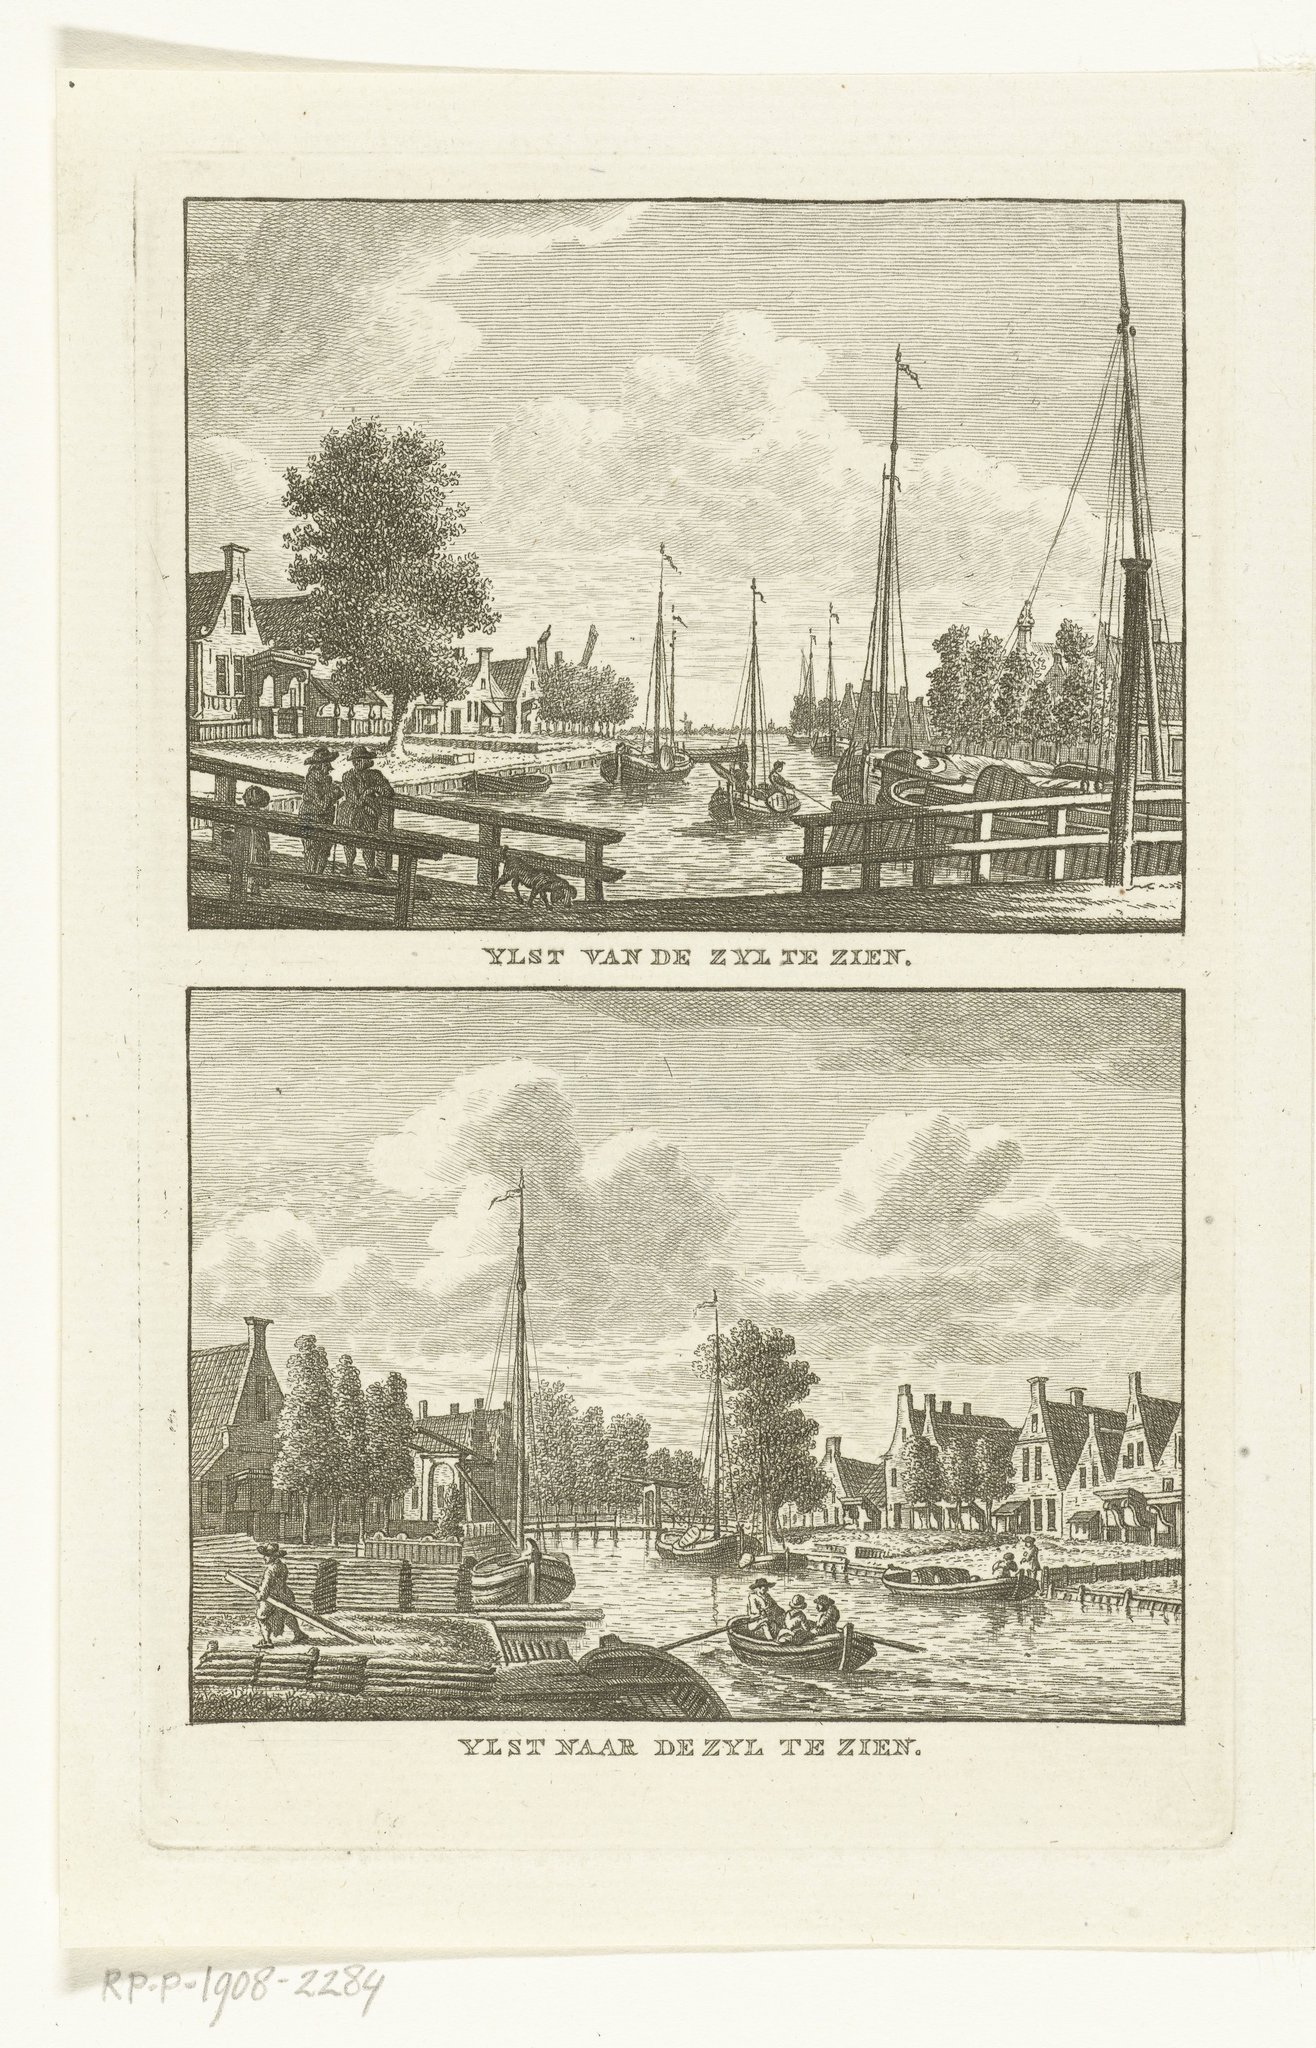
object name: print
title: Ylst naar de zijl gezien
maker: carel frederik bendorp (i)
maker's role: print maker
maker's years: 1736-1814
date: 1786-1792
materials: paper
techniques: etching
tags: harbour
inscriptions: collector's mark: Lugt 2228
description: Prent uit: Vaderlandsche gezichten, of afbeeldingen van den tegenwoordigen staat der Vereenigde Nederlanden (…). Amsterdam: Hendrik Gartman, Willem Vermandel en Jan Willem Smit, 1786-1792. Uitgegeven in afleveringen met ieder een eigen bifolium en inhoudsopgave. Alle prenten in deze publicatie zijn gegraveerd door Carel Frederik Bendorp (I) en, in de meeste gevallen, gebaseerd op tekeningen van Jan Bulthuis.